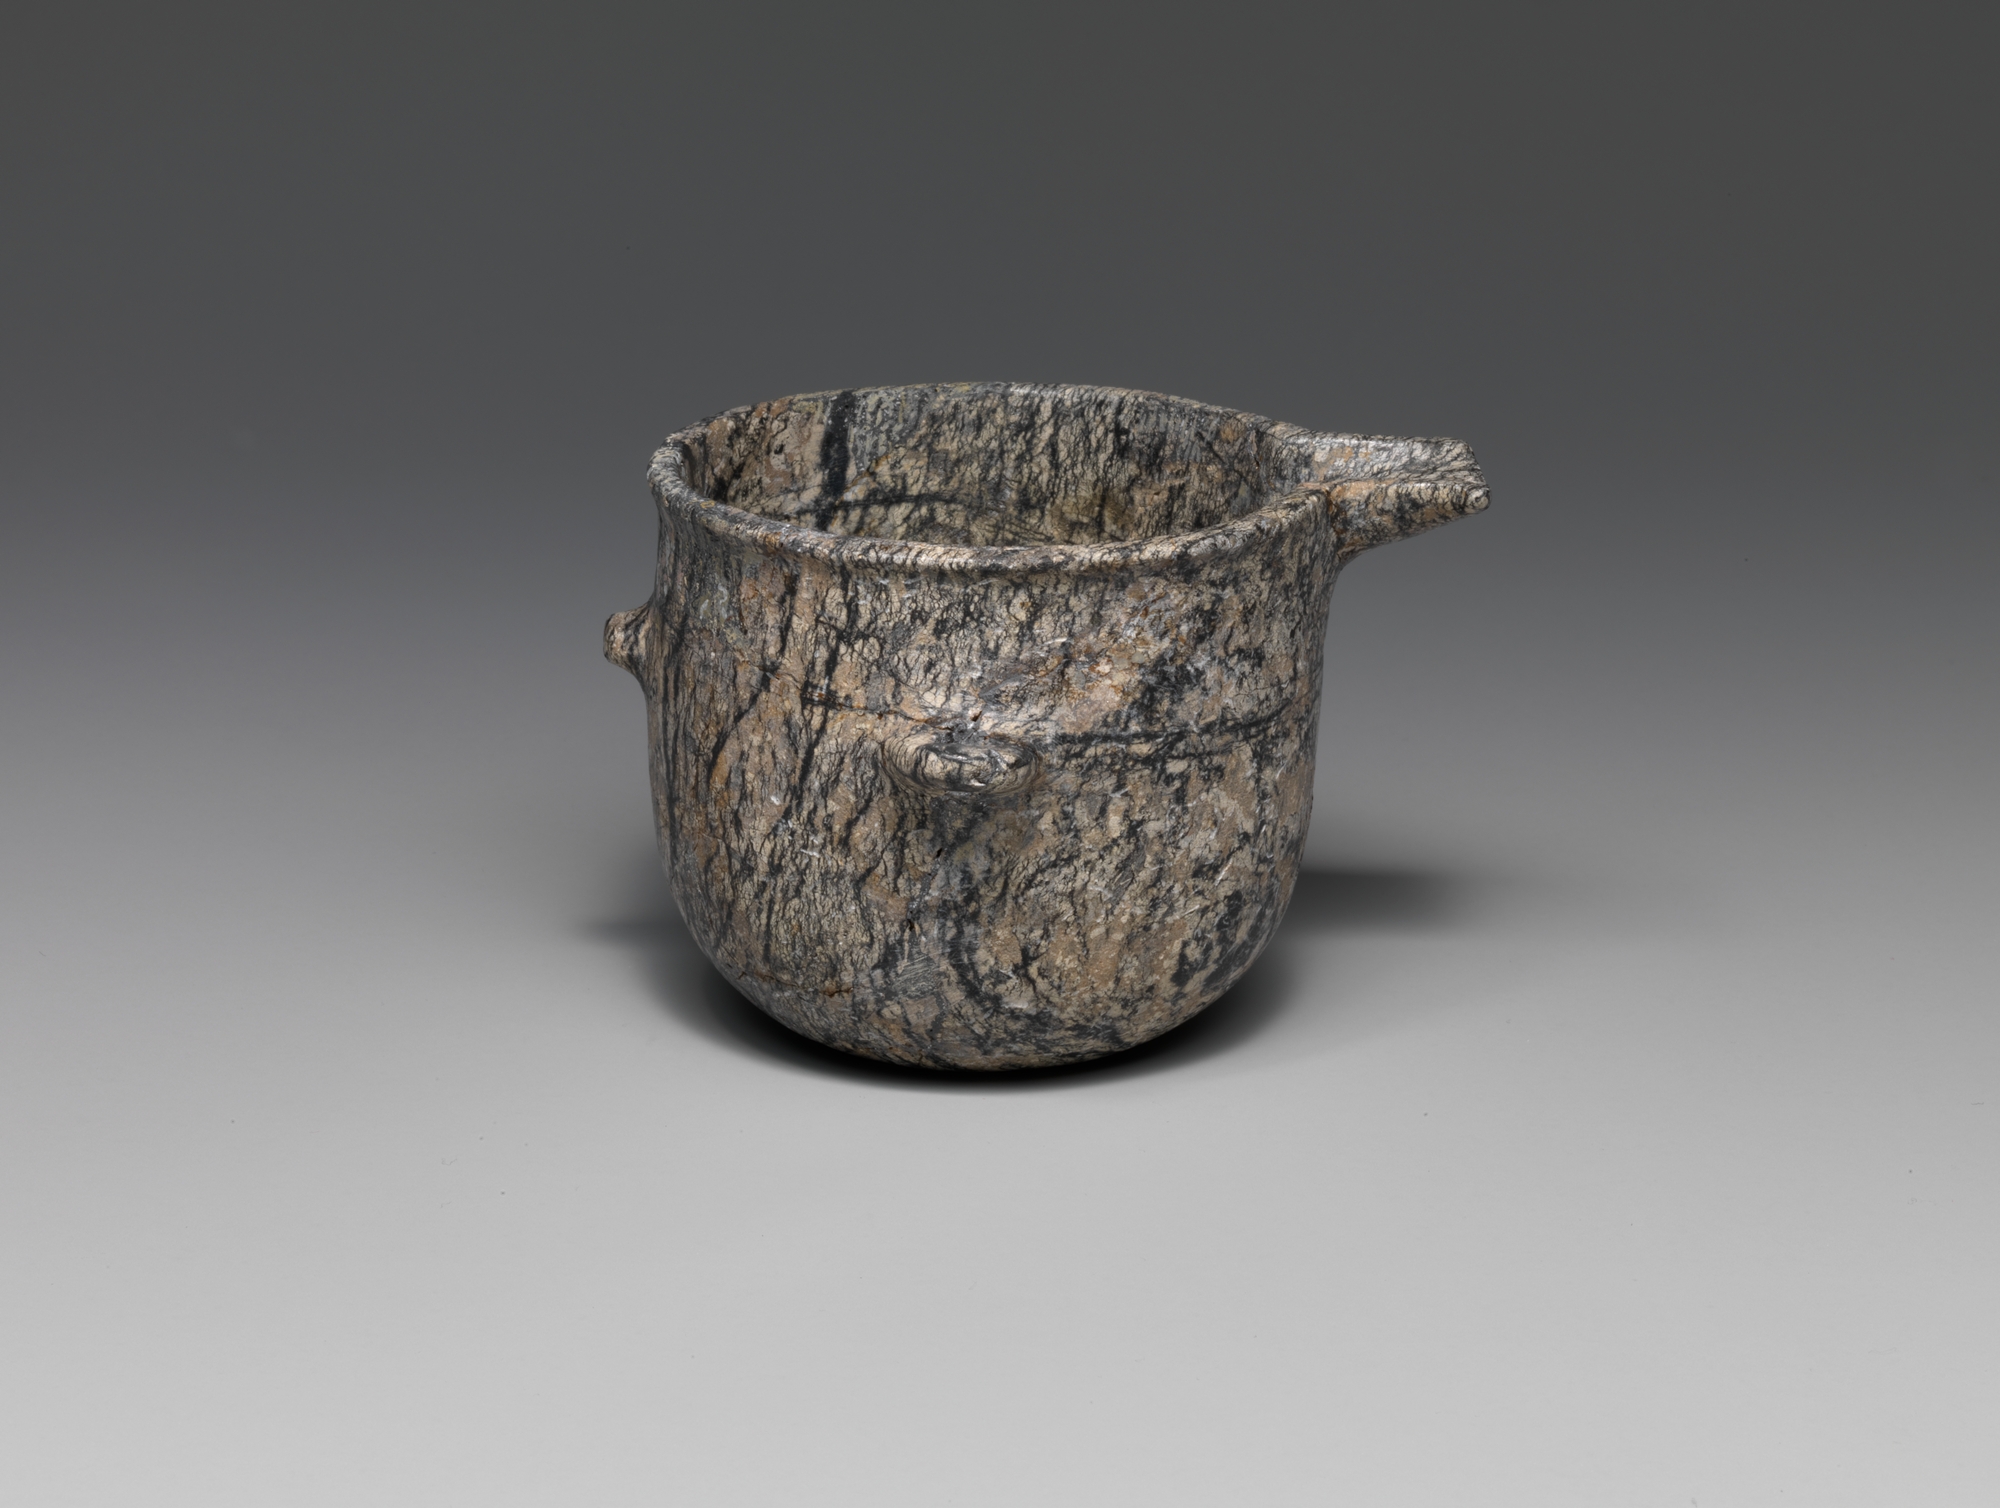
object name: cup with spout and lug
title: Steatite vase with spout and lugs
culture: minoan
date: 2600-1900 BCE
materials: stone